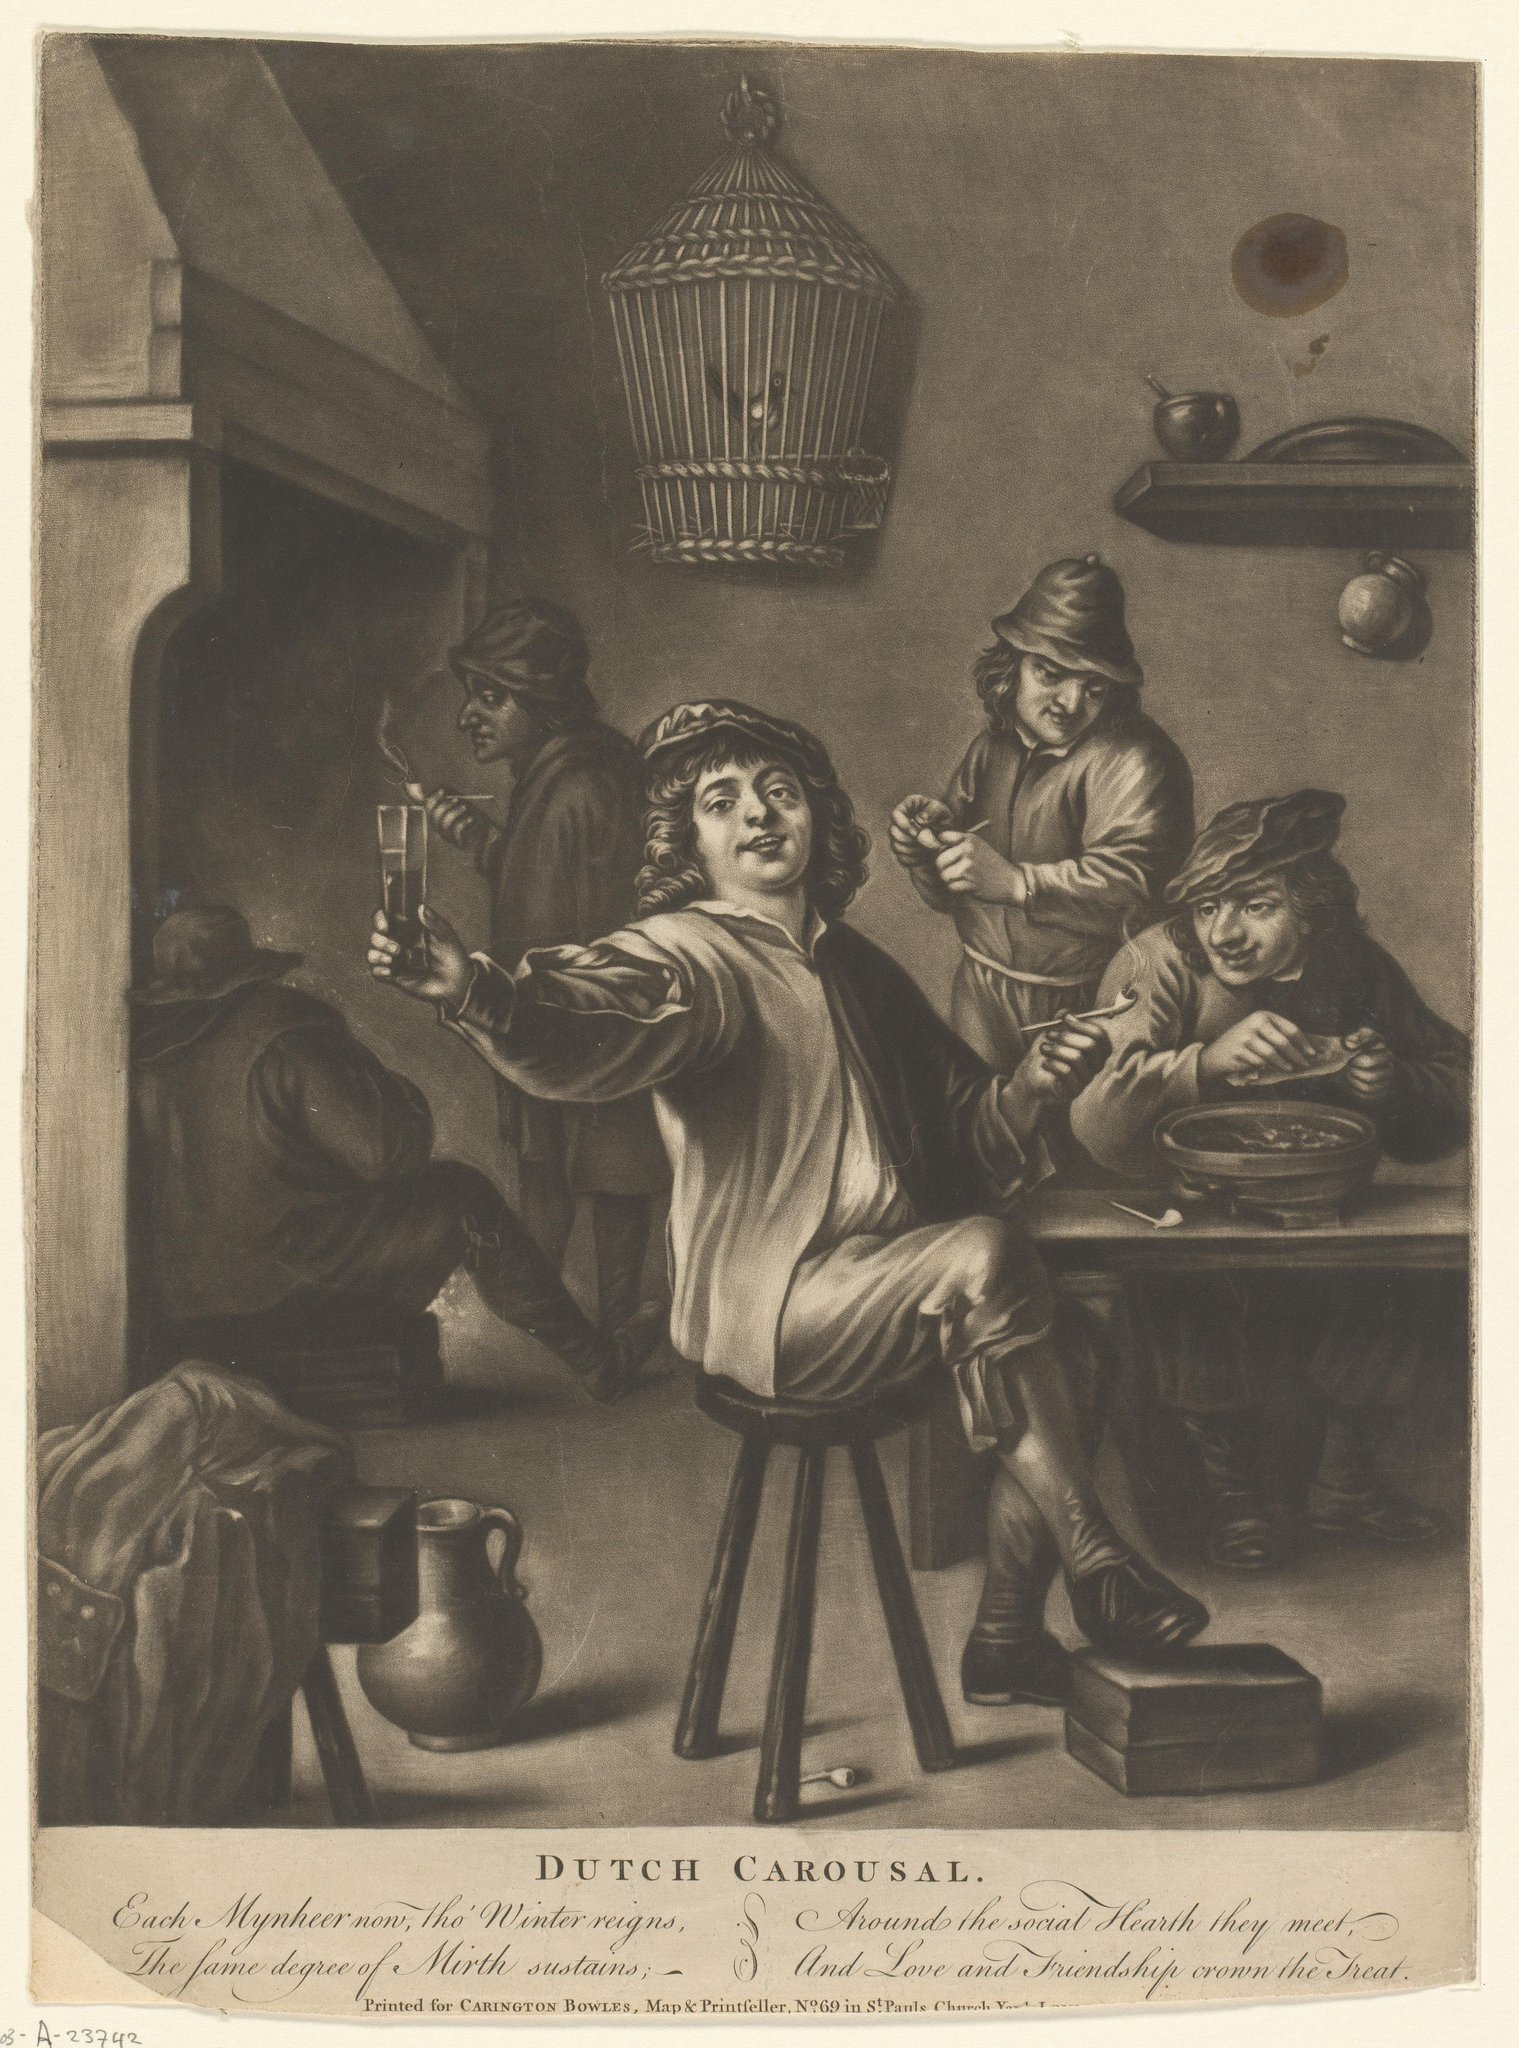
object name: print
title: Herberginterieur met vijf rokende en drinkende mannen bij een schouw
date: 1762-1793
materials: paper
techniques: etching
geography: england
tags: open hearth, fire-place, alcoholic drinks, pipe ~ tobacco (+ taking (particular) foodstuffs: eating, drinking, smoking, chewing, etc.), bird in a cage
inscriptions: collector's mark: Lugt 2228